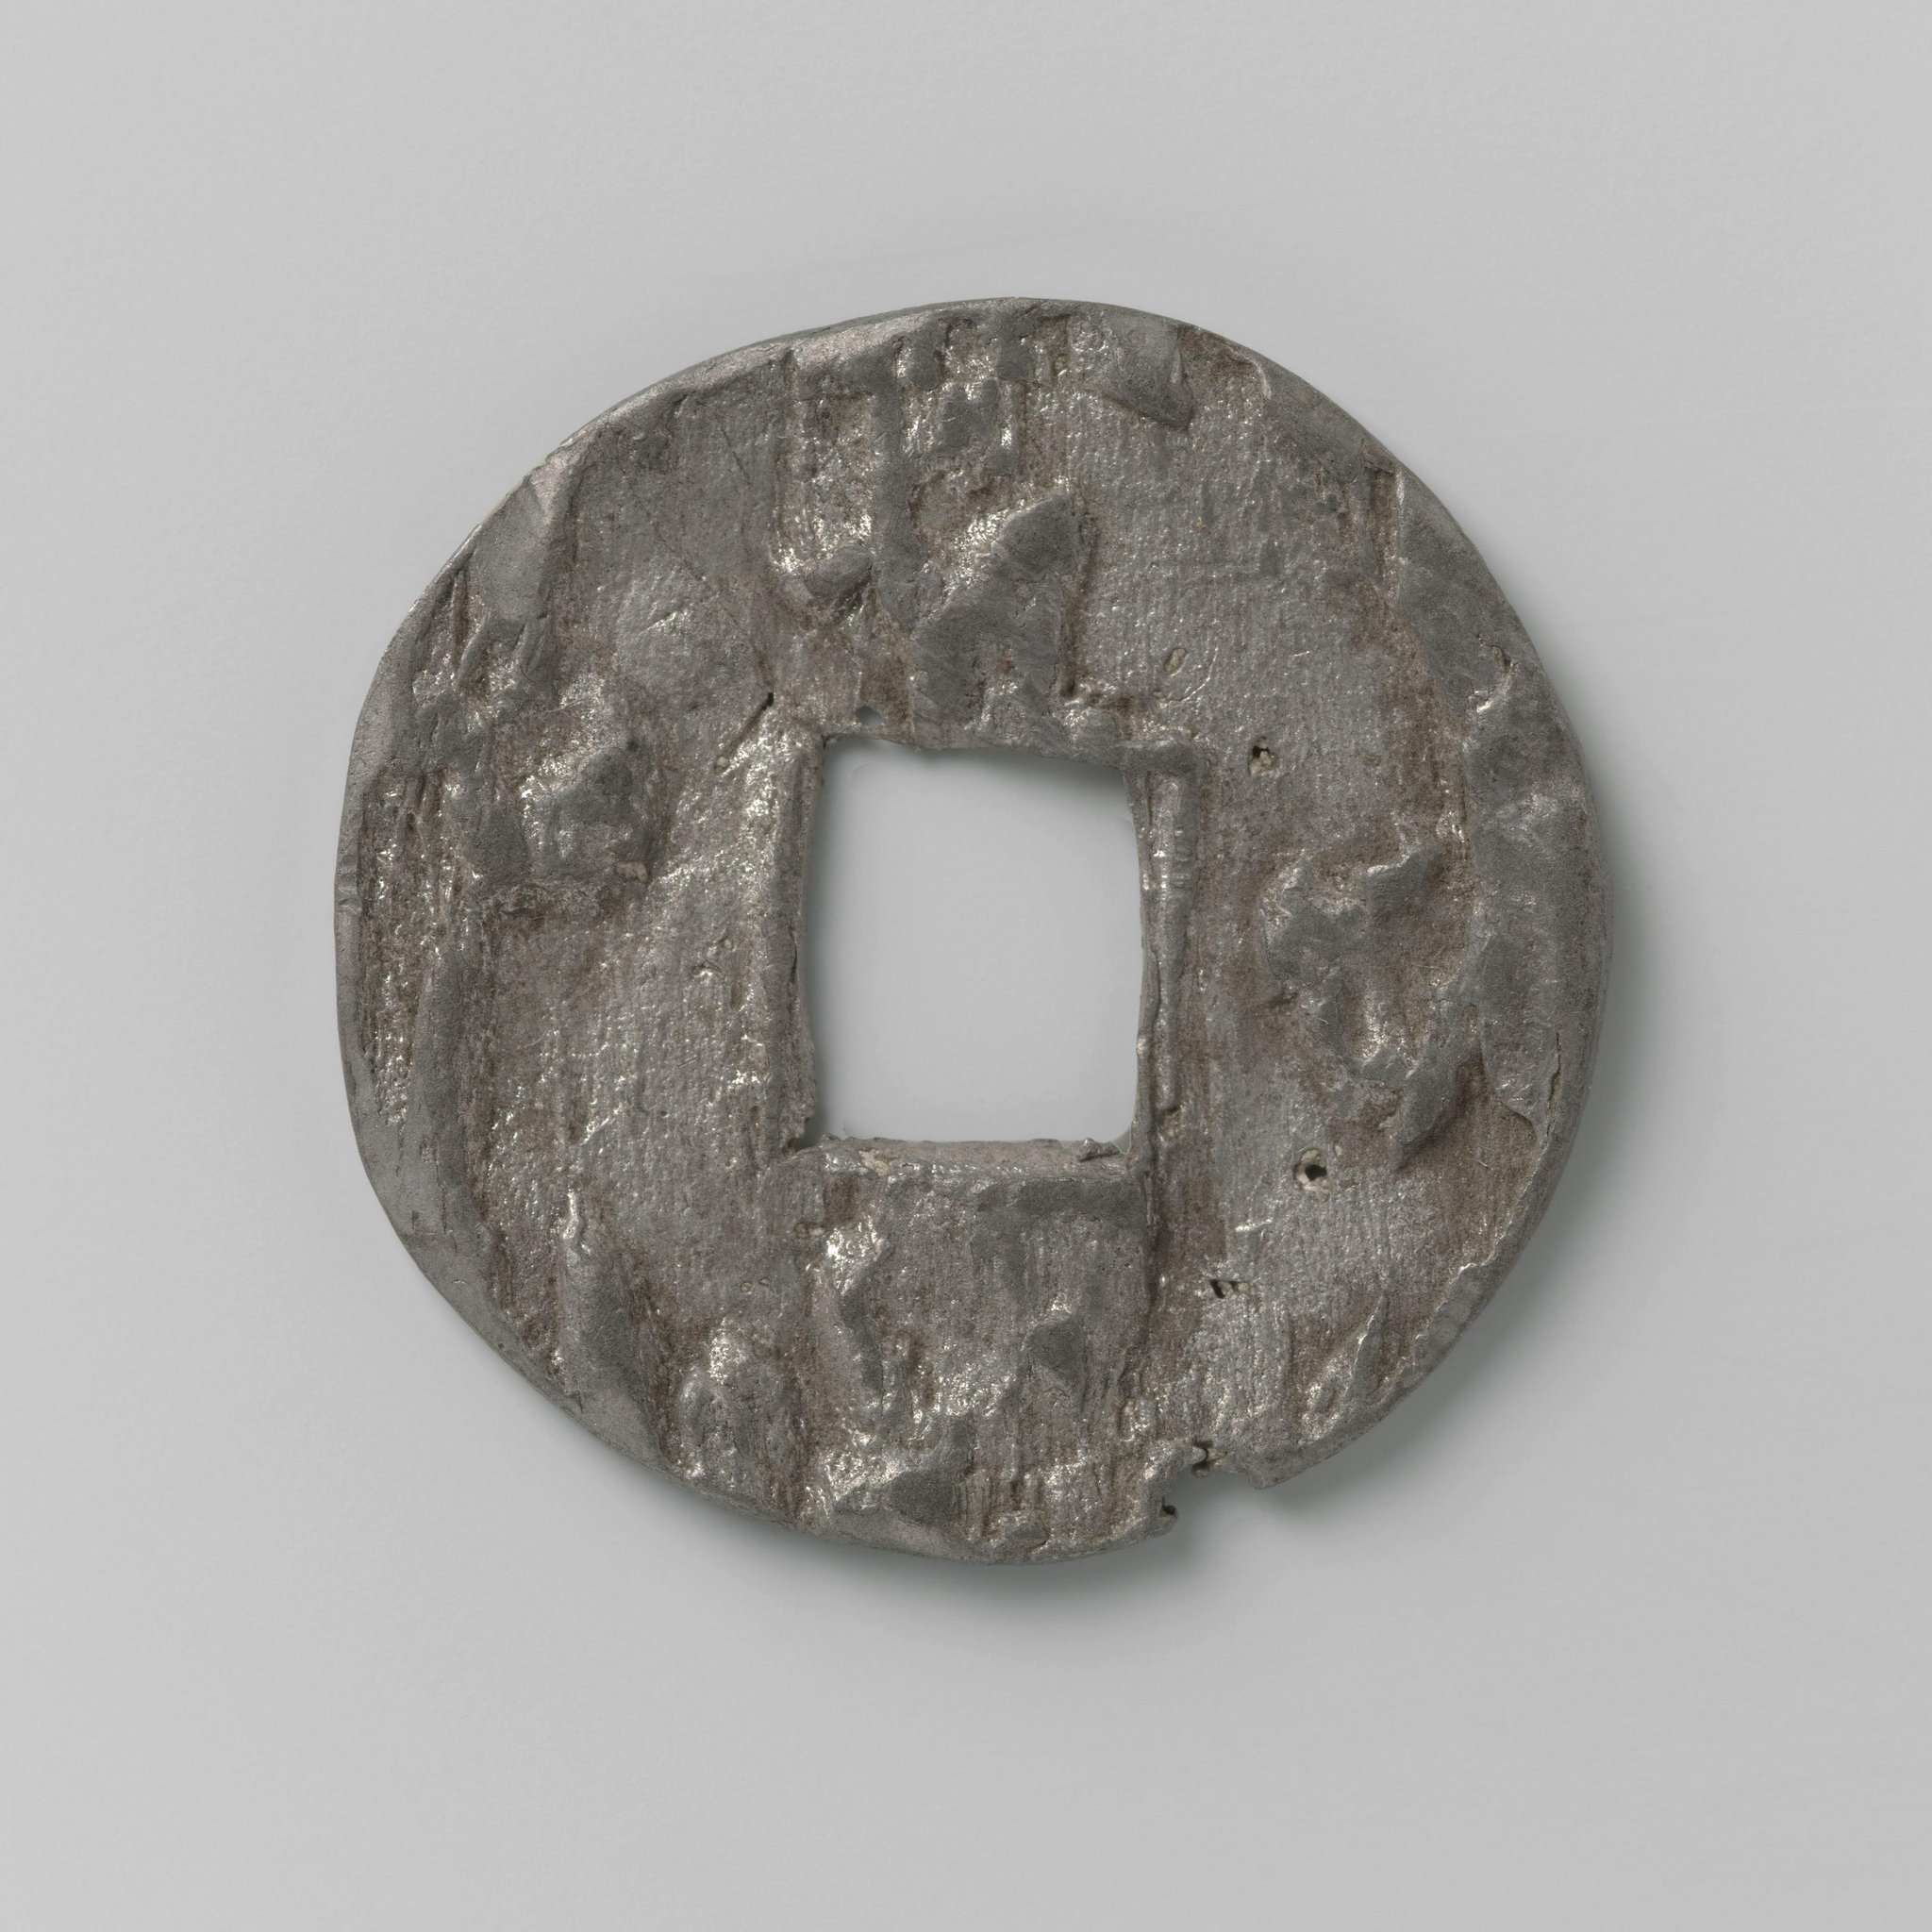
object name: coin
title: Keteng van Soerakarta, Java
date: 1700-1800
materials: tin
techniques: casting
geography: soerakarta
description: Tinnen munt. Voorzijde: vier karakters. Keerzijde, glad. In het midden vierkant gat.